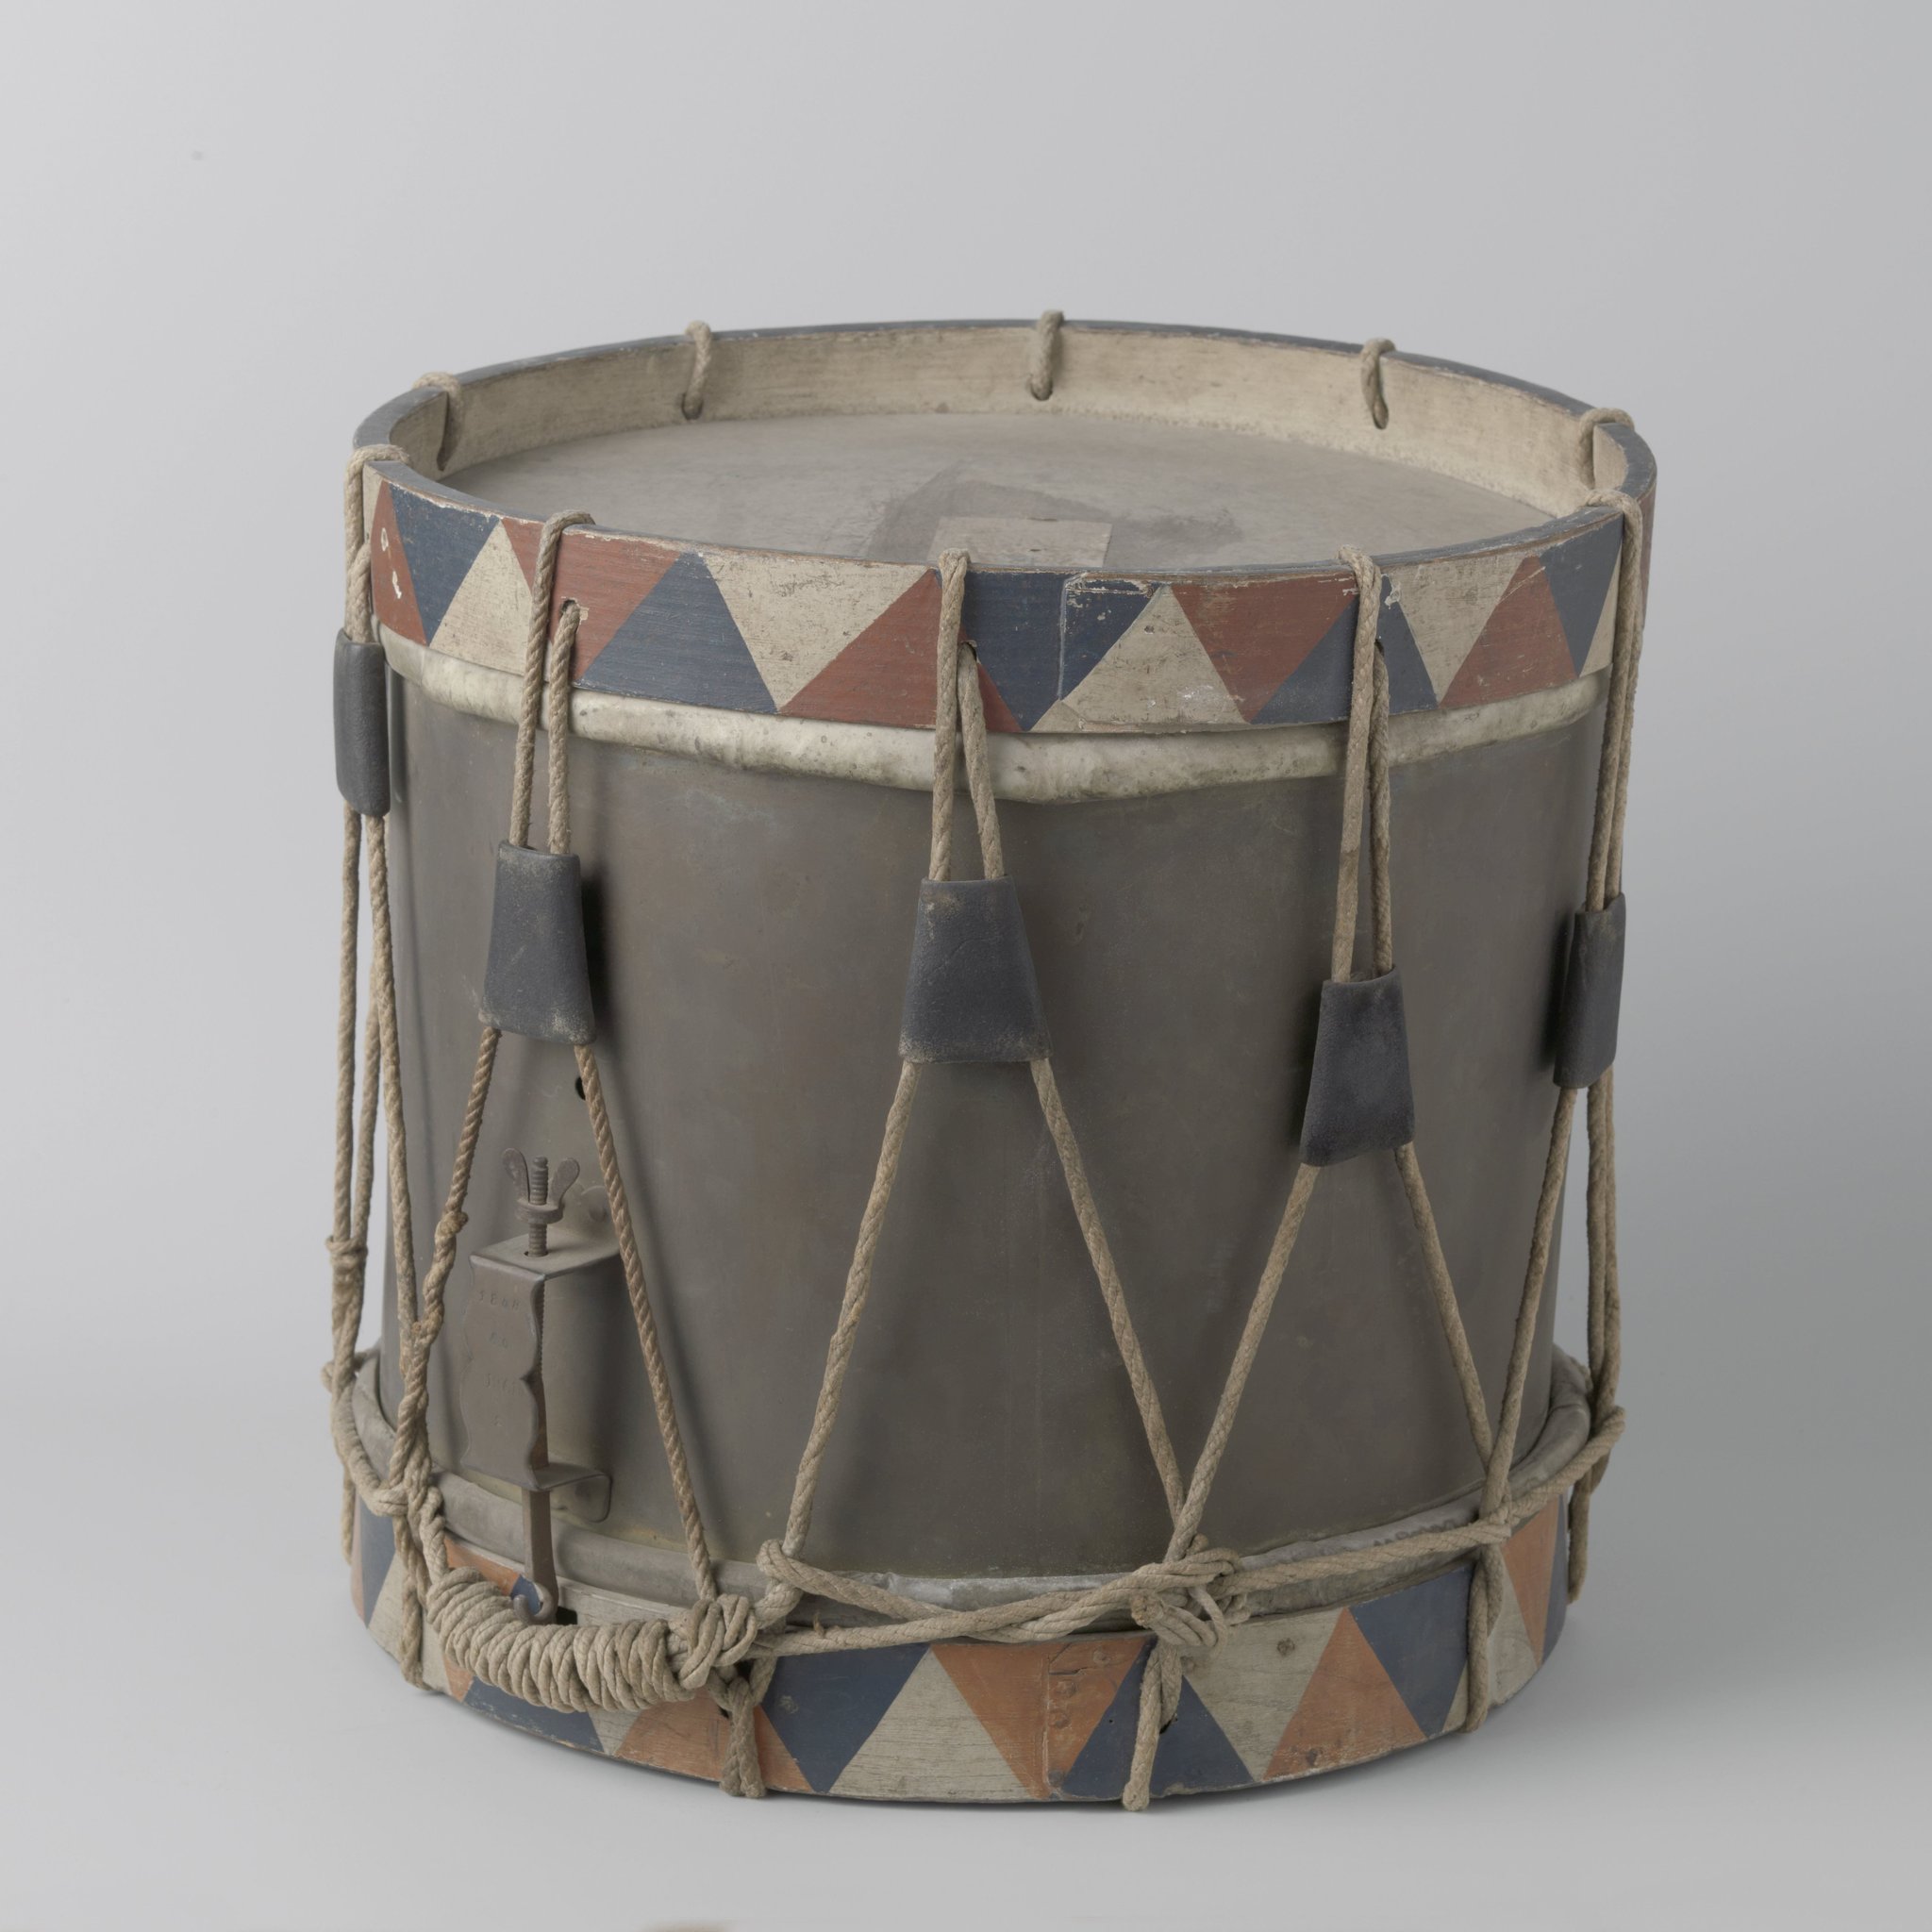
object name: percussion instrument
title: Side Drums (39 x)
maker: Anonymous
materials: brass, leather, fiber, wood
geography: netherlands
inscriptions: inscription: ‘1848-50 en 1861-2’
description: Music has always been a crucial element of public celebrations, such as military parades, coronations, royal weddings, and funerals, adding grandeur to the solemnity of the occasion. Musical ensembles entrusted with performing music at these events have existed in Europe since the Middle Ages. This display highlights various marching bands and their musical instruments dating from the 16th to the 19th century.